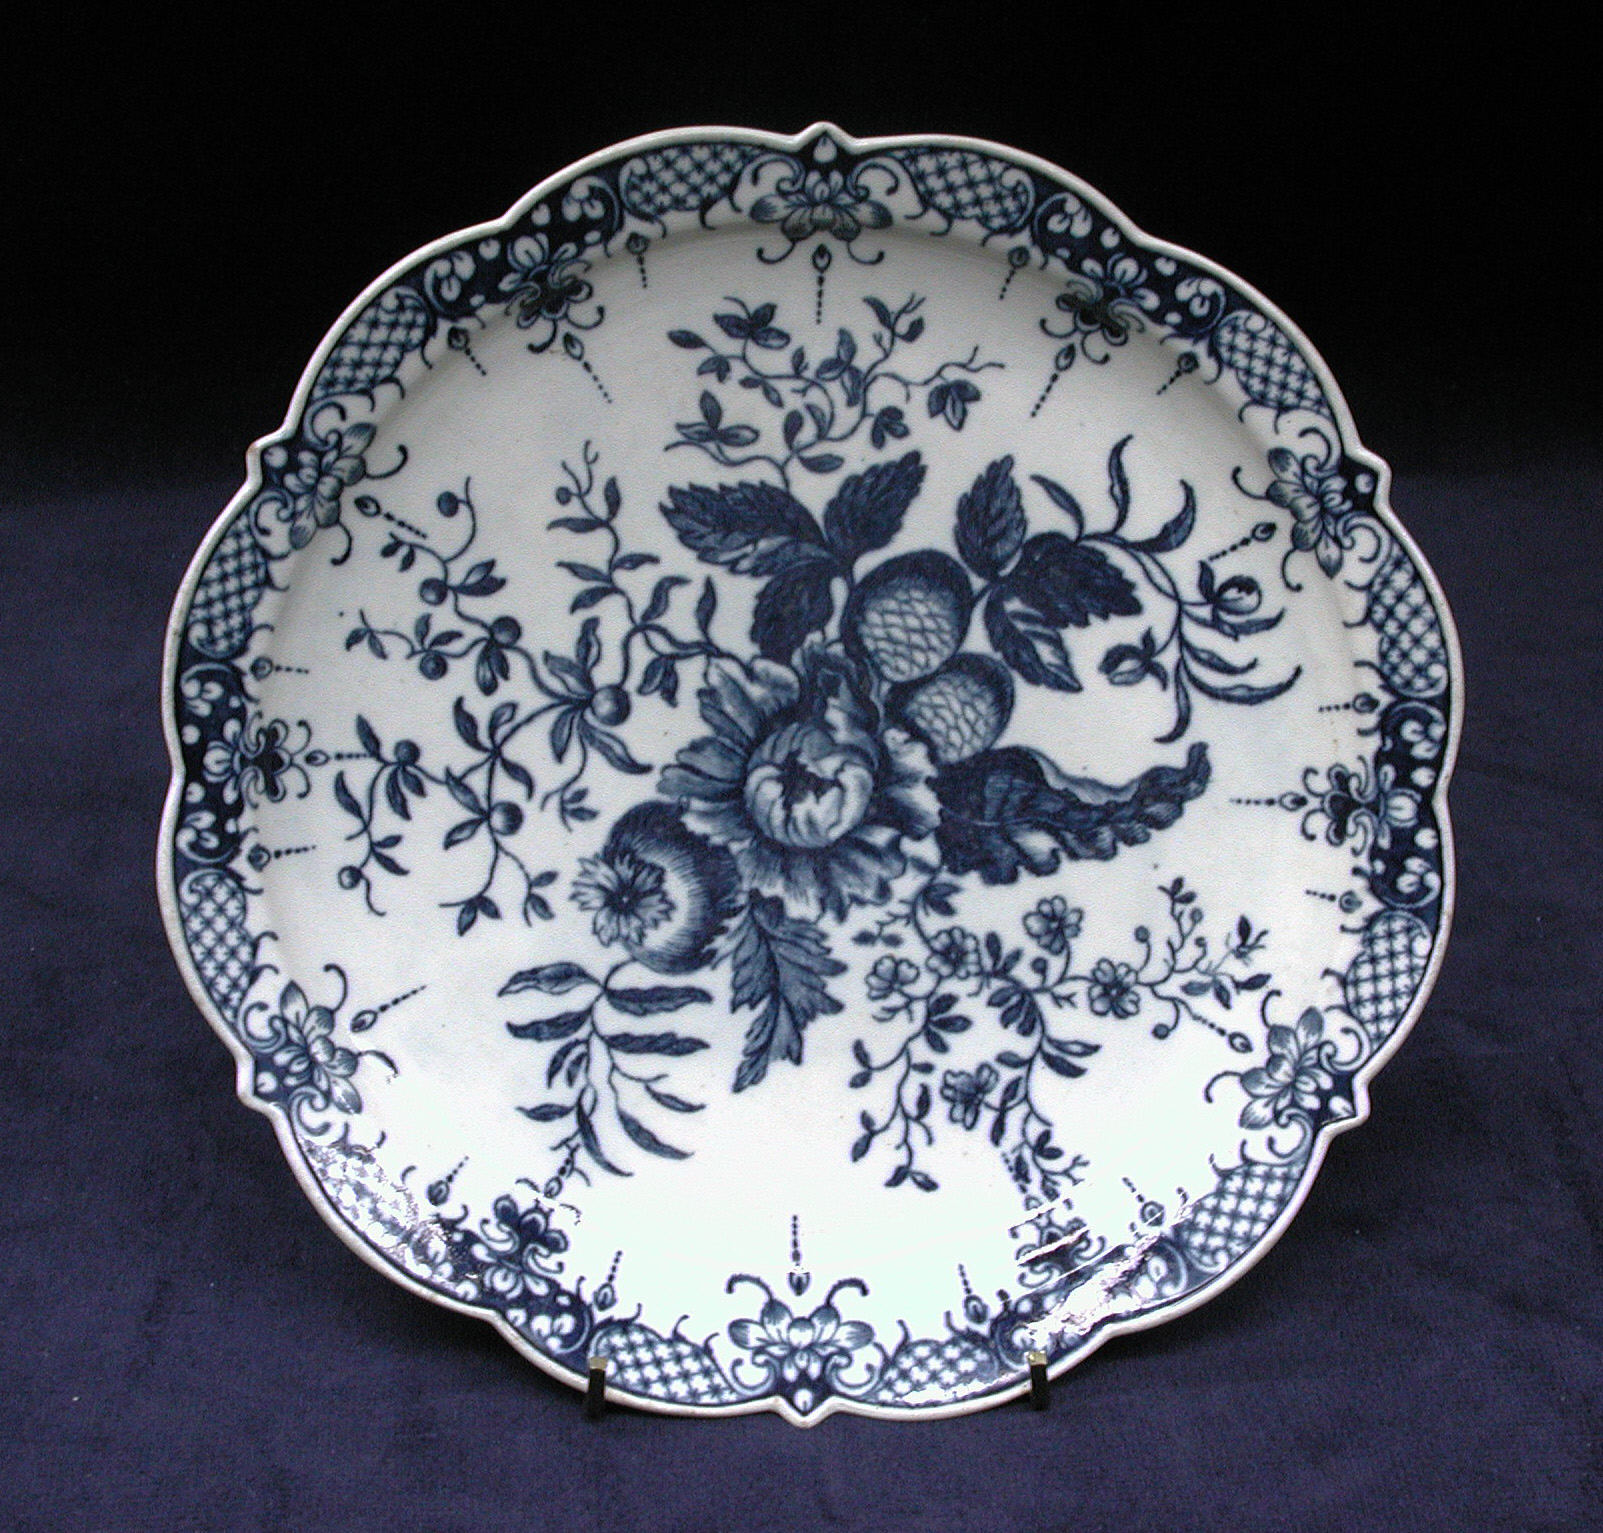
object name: plate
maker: worcester factory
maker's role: factory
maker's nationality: british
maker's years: 1751-2008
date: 1770-1780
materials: soft paste porcelain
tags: fruit,flowers